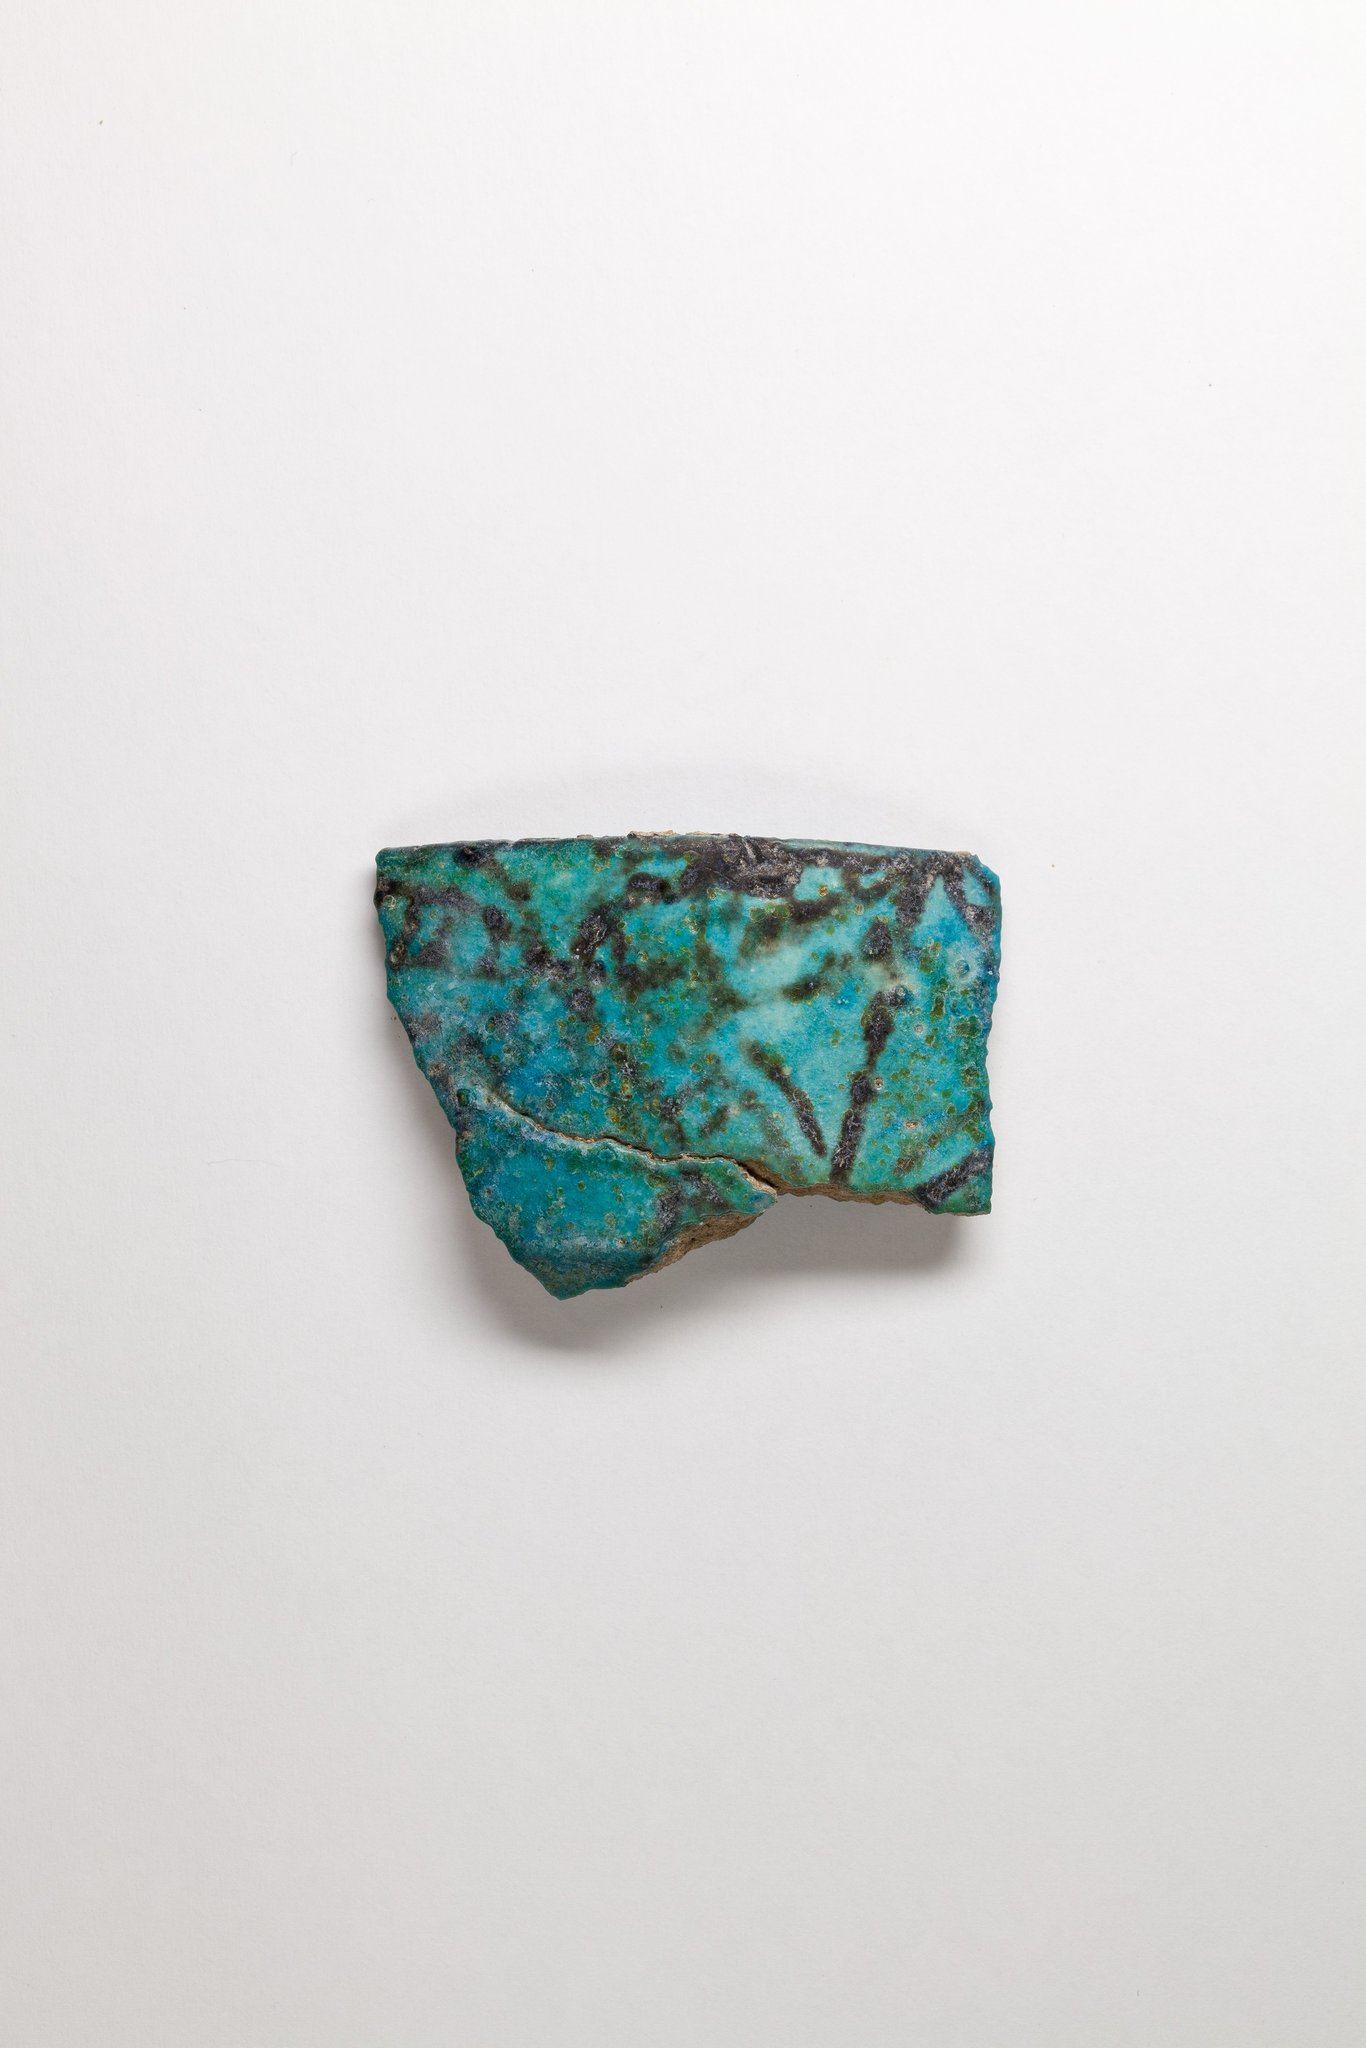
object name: vase fragment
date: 1981-1640 BCE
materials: faience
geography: egypt